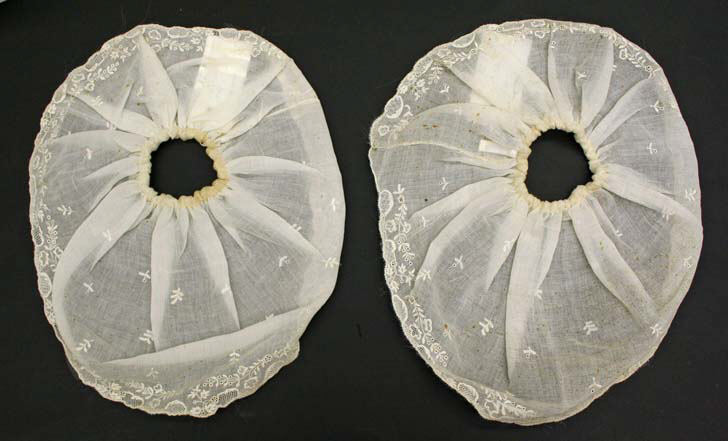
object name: engageantes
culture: british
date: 1701-1800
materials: cotton